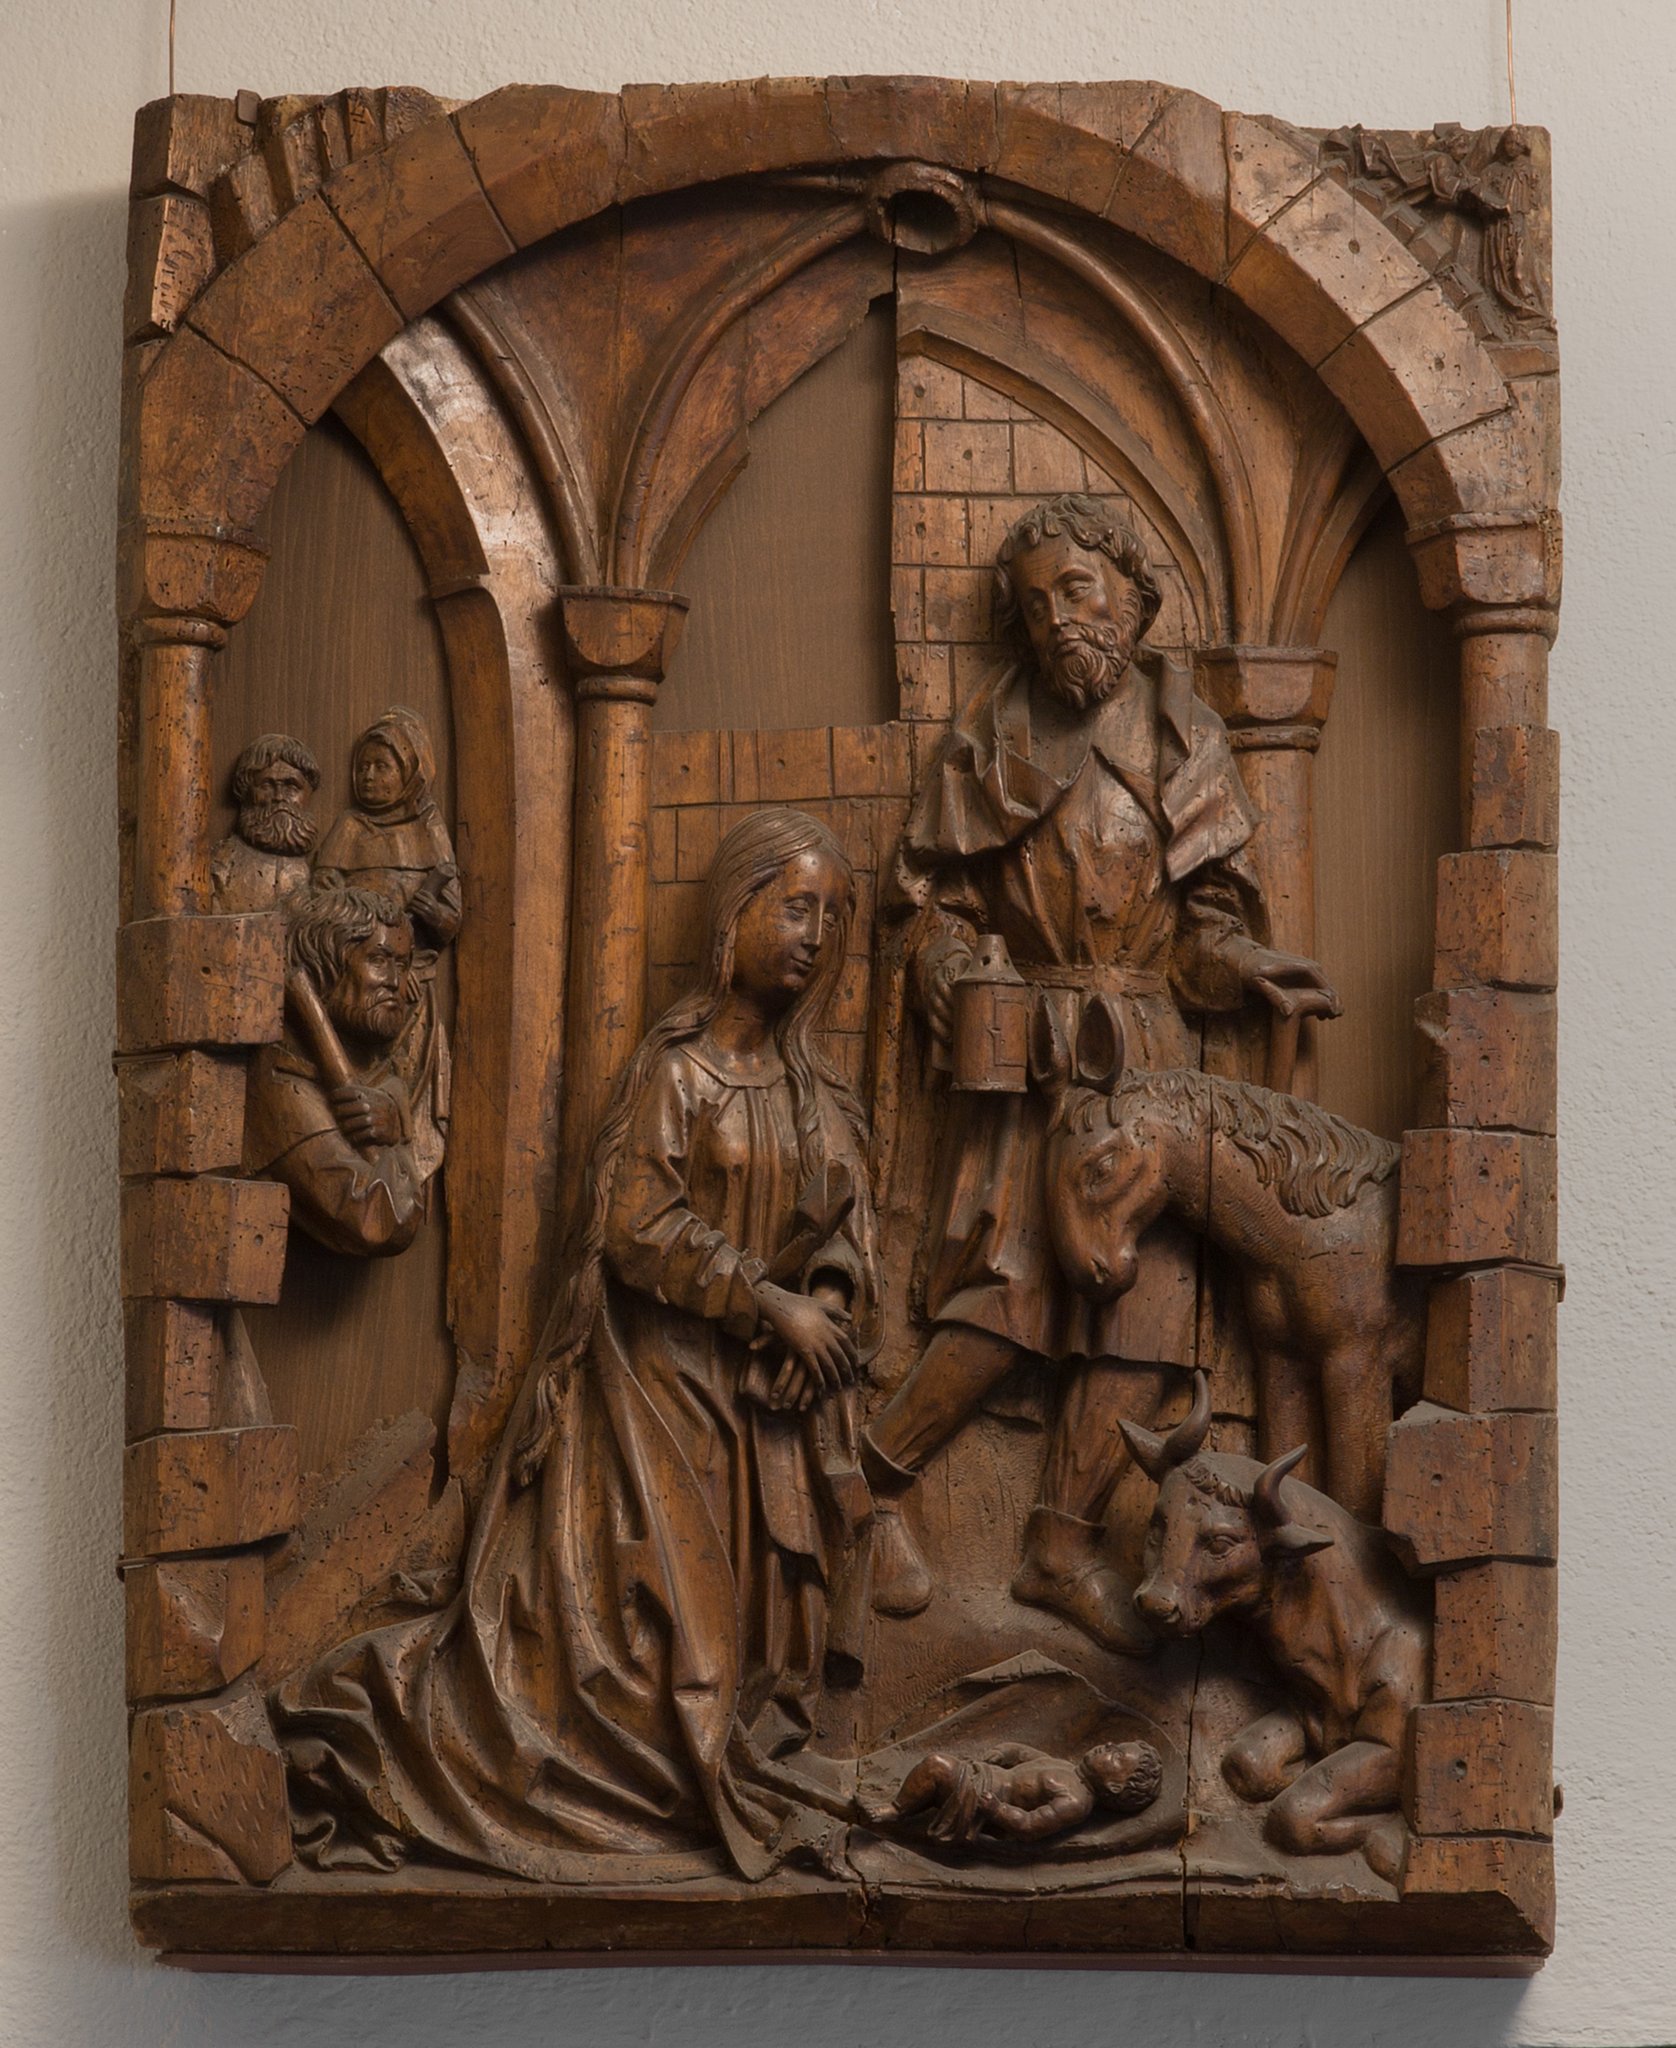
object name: relief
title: Nativity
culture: german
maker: alsatian master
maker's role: artist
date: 1501-1600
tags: donkeys,jesus,nativity,ox